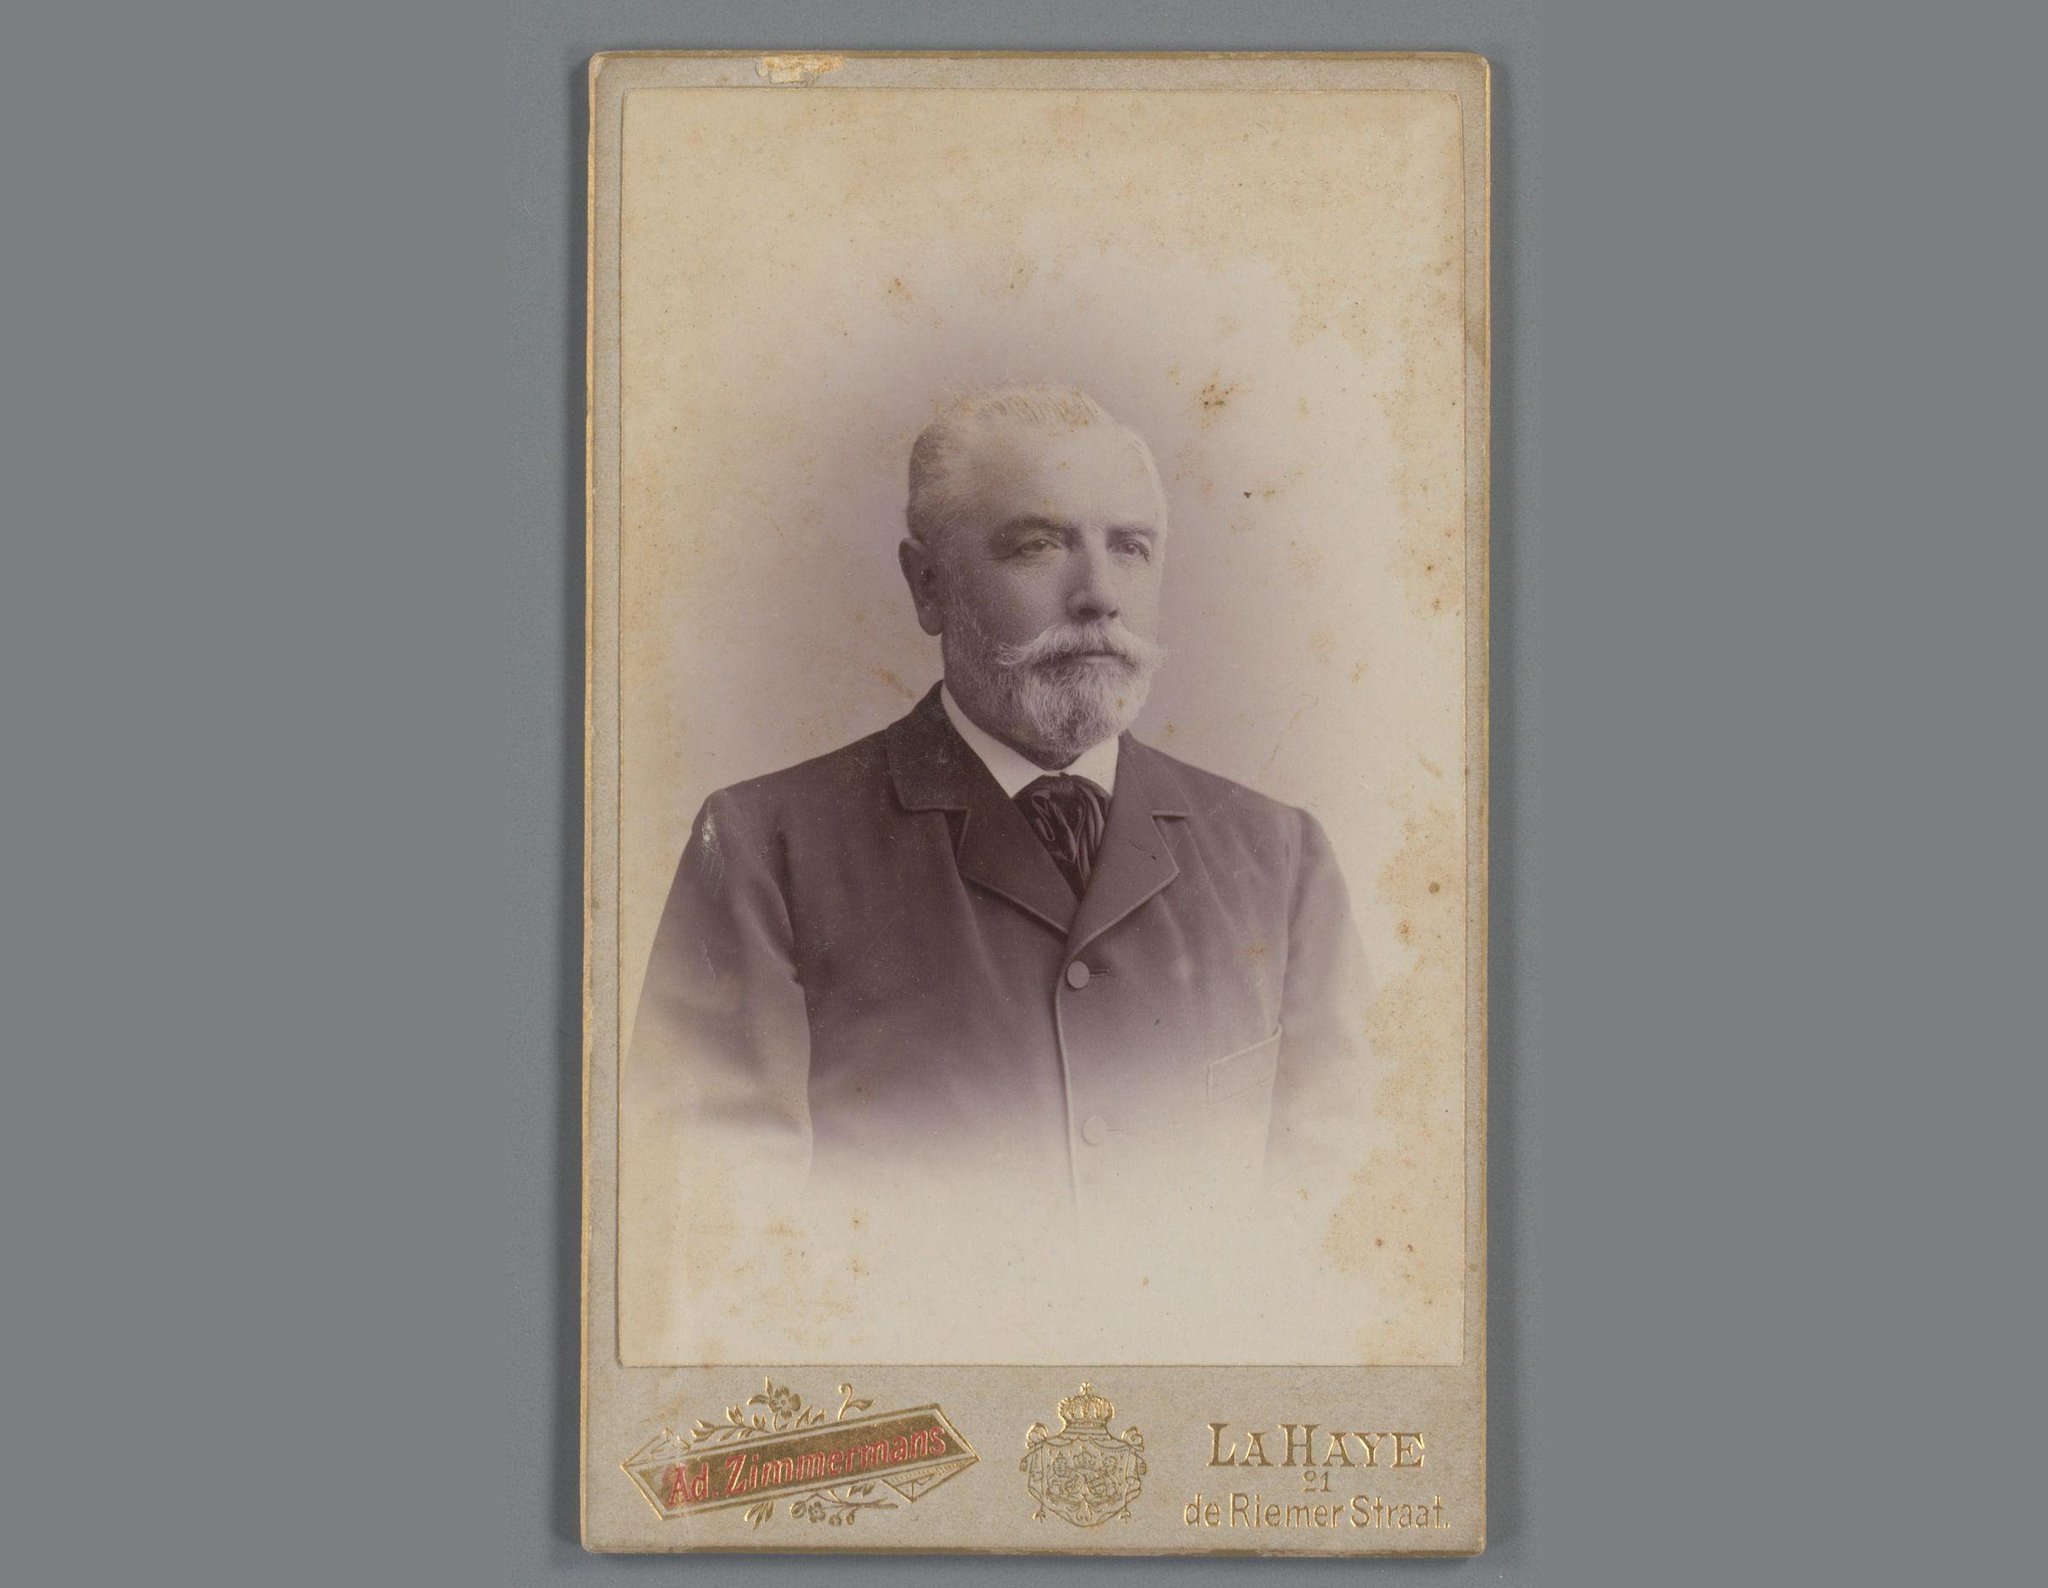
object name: photograph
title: Portret van een onbekende man, mogelijk een lid van de familie Onnen-van den Berg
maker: adolphe zimmermans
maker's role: fotograaf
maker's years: 1858-1922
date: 1884-1913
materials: paper, cardboard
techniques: collodion silver print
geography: the hague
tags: anonymous historical person portrayed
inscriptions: address: ‘La Haye/ 21/ de Riemer Straat’